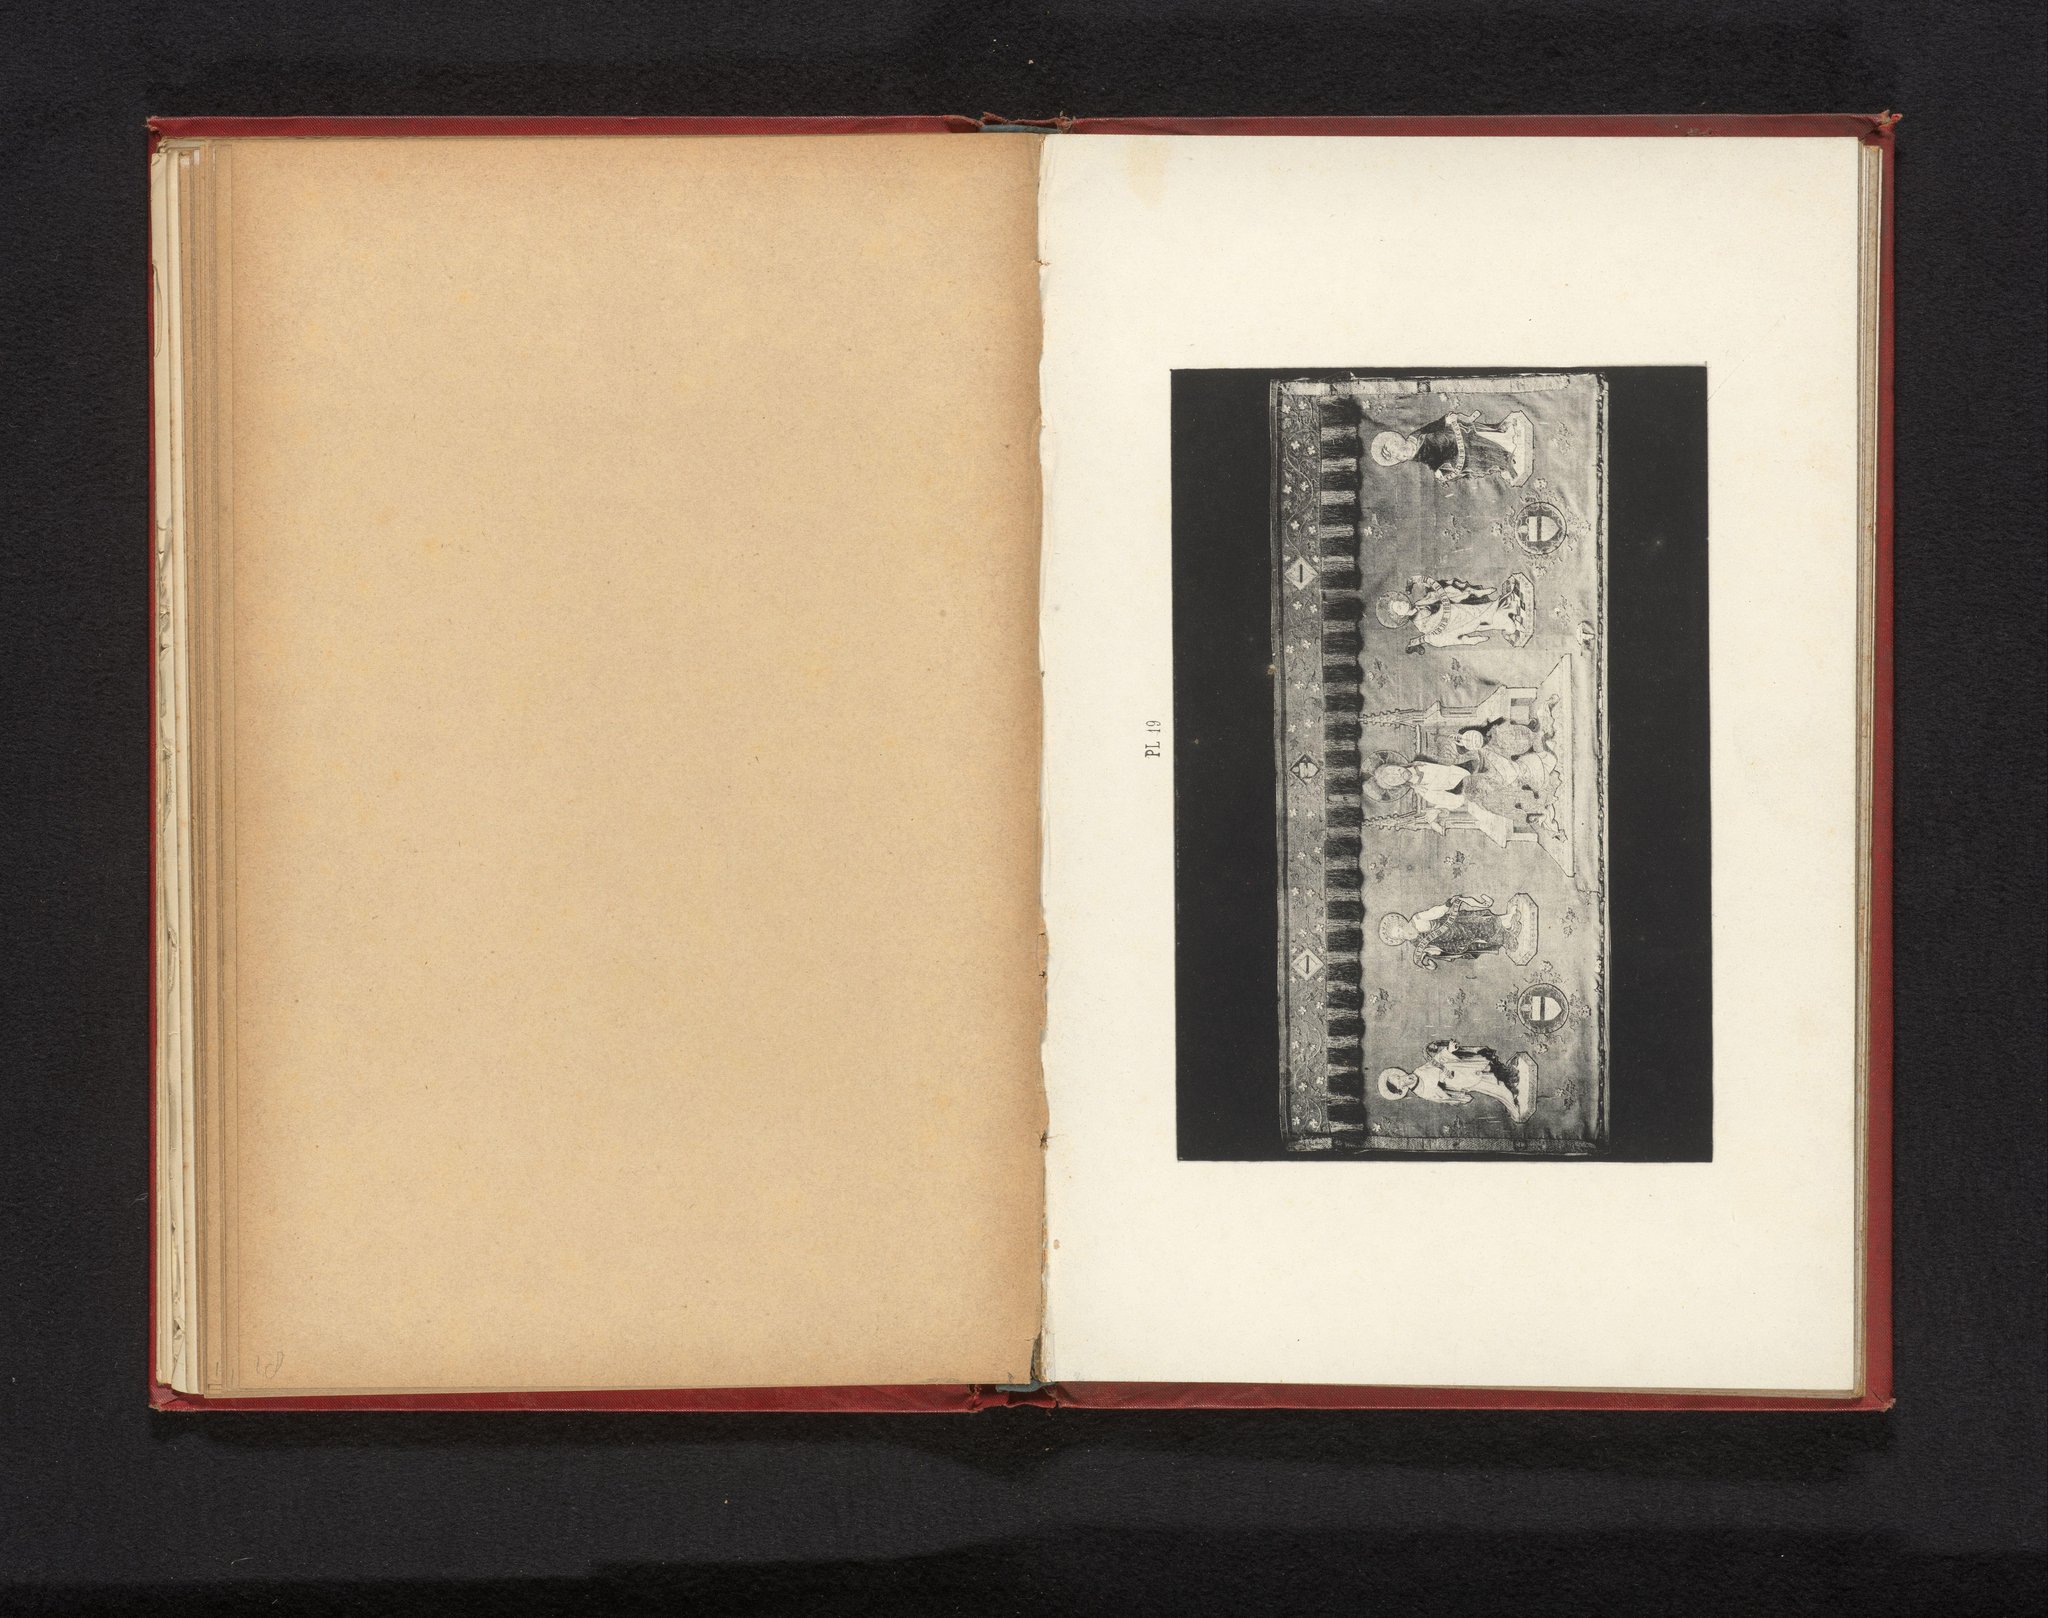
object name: page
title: Tapijt met afbeeldingen van Christus en heiligen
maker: Anonymous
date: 1880-1881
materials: paper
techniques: photograph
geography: barcelona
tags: carpet, rug, saints, christ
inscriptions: number: ‘Pl 19’